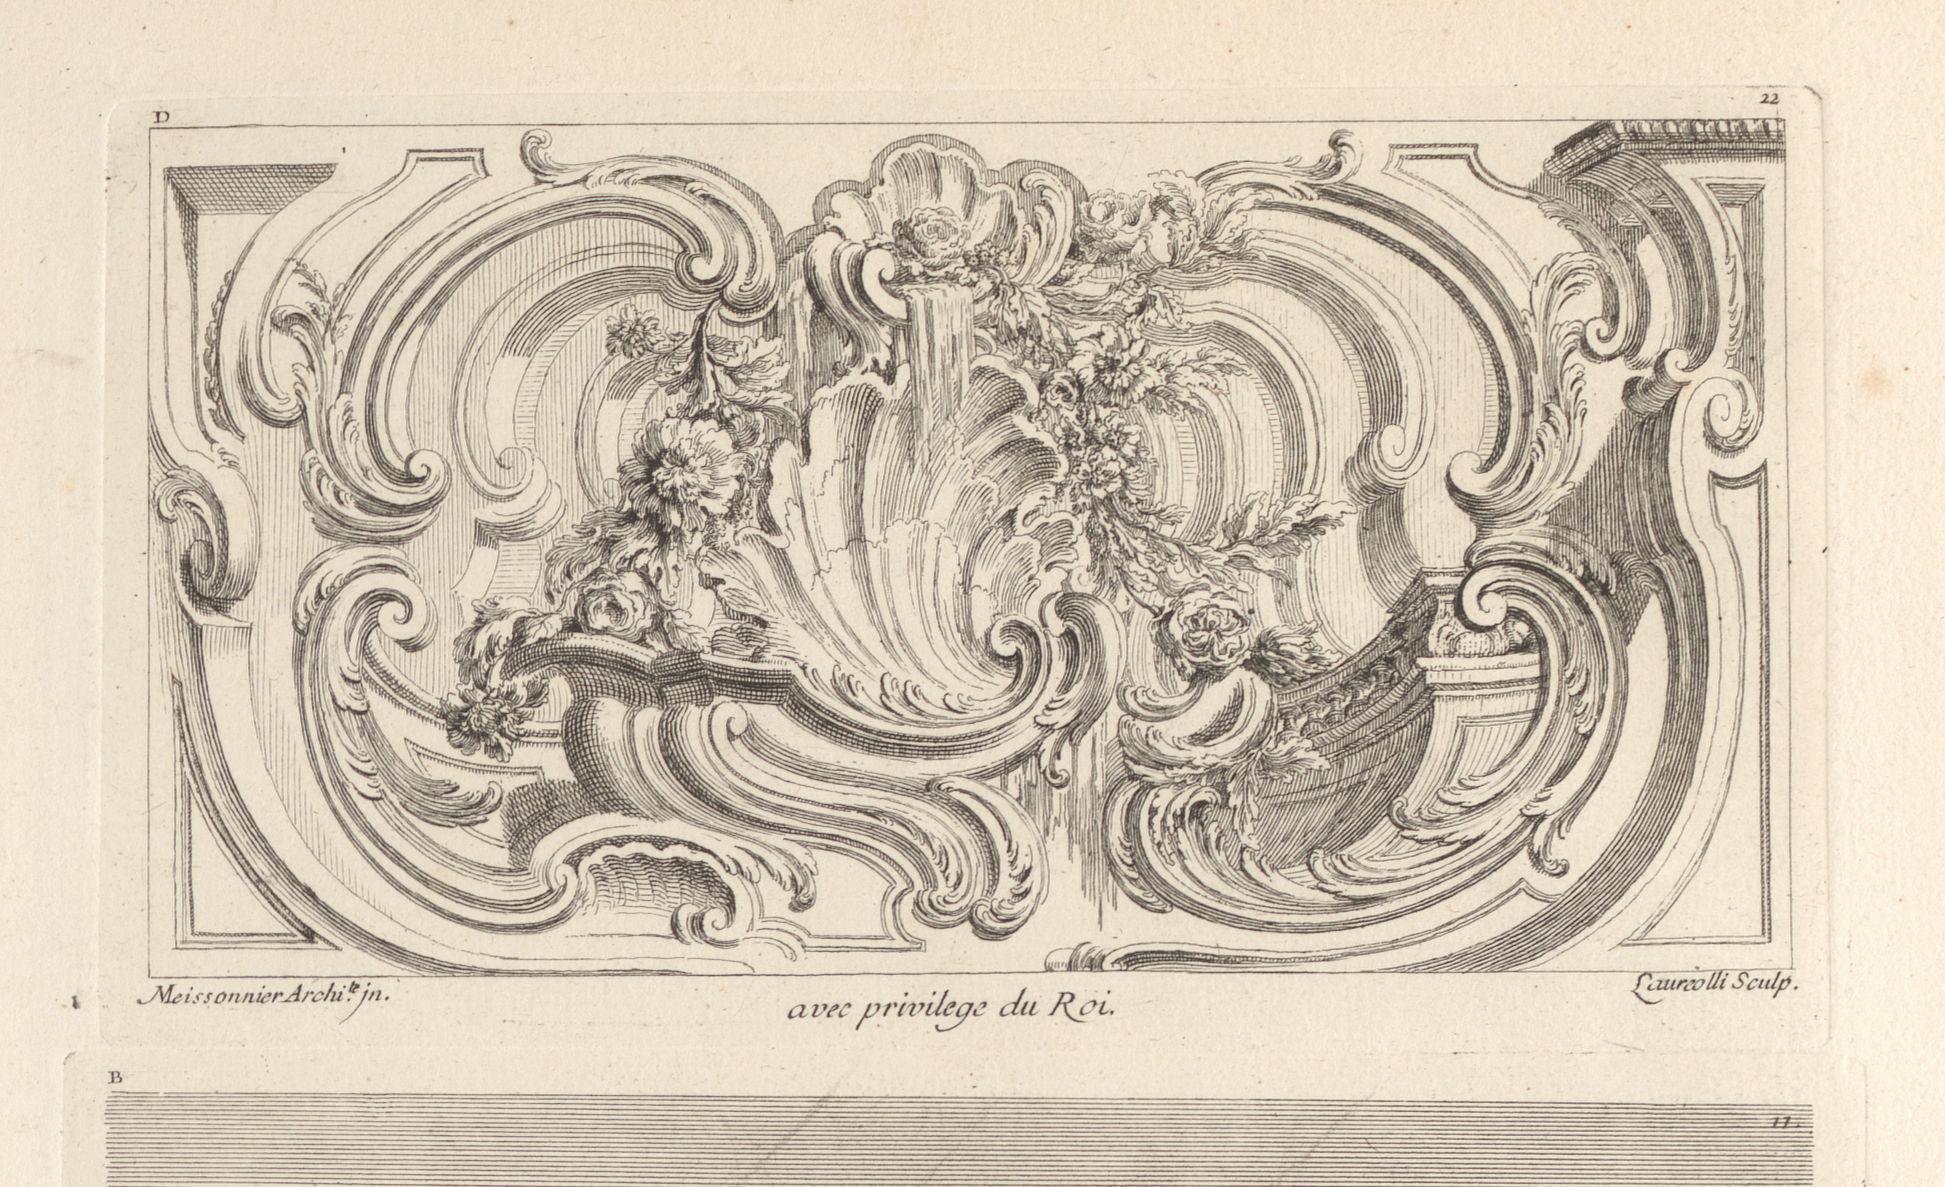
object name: ornament print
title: Panneaux d'ornements rocaille, sept planches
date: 1738-1749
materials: paper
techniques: etching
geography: paris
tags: scallop, shell ~ ornament, ornament ~ festoon, garland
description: Prent uit een serie van zeven etsen met rocailles.